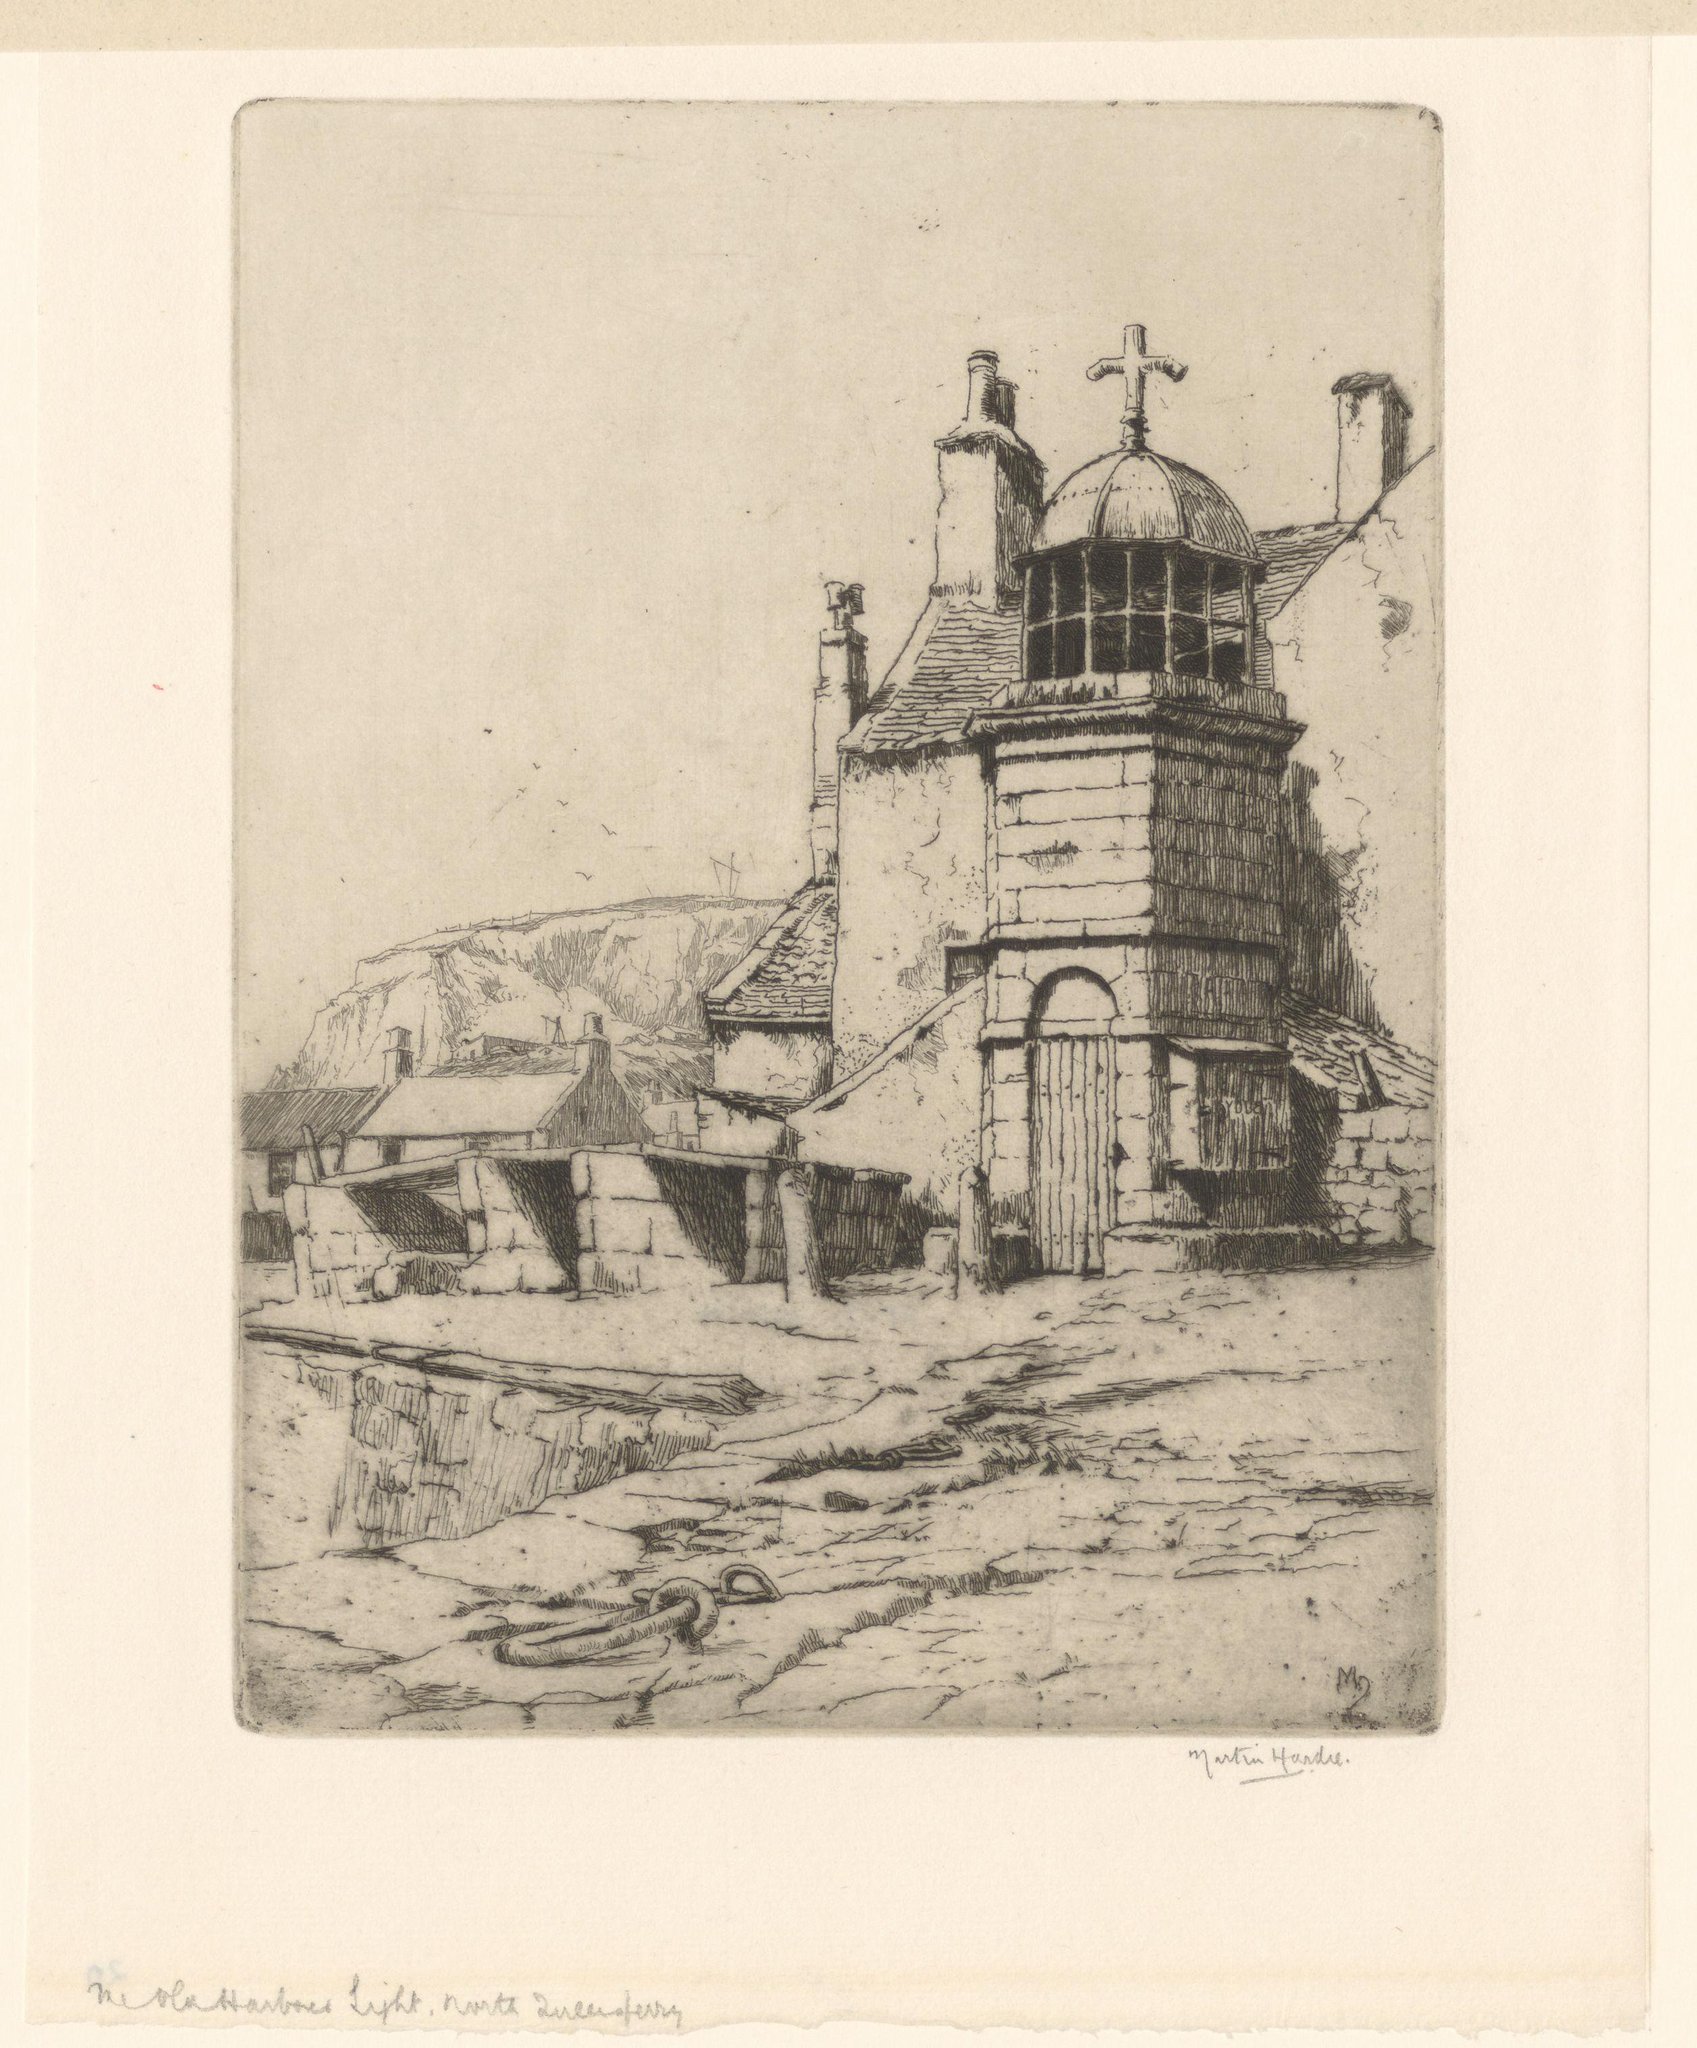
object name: print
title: The Old Harbour Light: North Queensferry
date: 1909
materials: paper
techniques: etching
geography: fife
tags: harbour, lighthouse, lightship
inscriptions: collector's mark: Lugt 2228, collector's mark: Lugt 2760, annotation: ‘Martin Hardie’